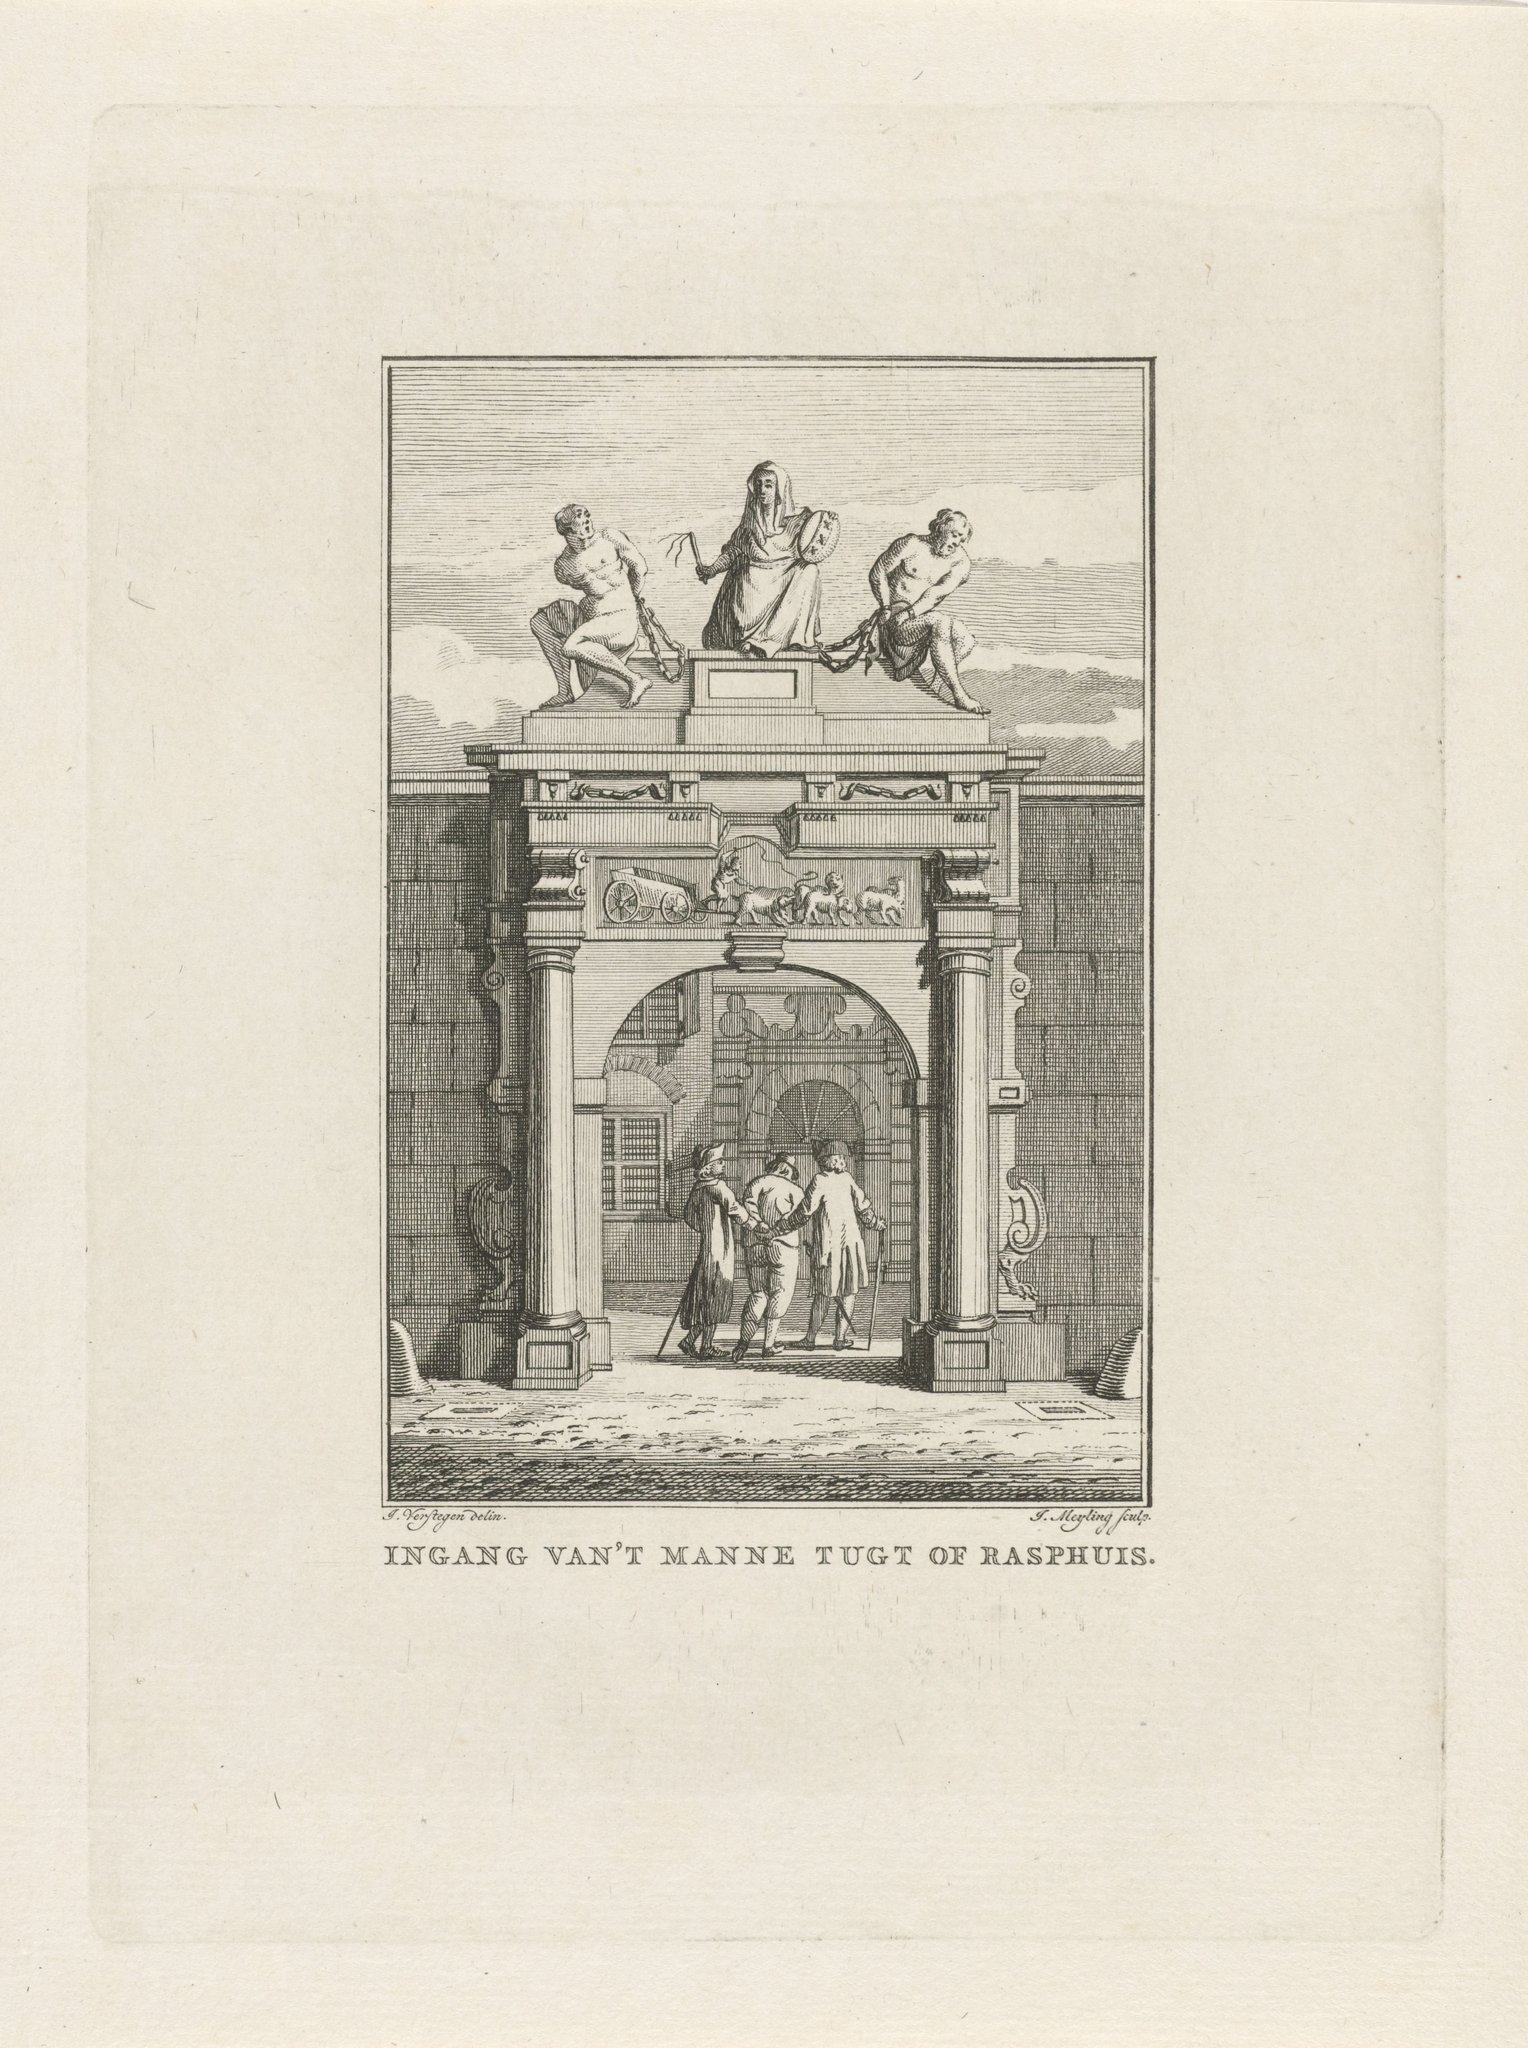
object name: print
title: Gezicht op de Rasphuispoort te Amsterdam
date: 1750-1800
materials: paper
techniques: etching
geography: amsterdam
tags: gate, entrance, punishment; 'castigo', 'pena', 'punitione' (ripa)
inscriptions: collector's mark: Lugt 2228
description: De poort van het Tucht- of Rasphuis aan de Heiligeweg in Amsterdam. De poort wordt bekroond door de Amsterdamse stedenmaagd als de personificatie van de tuchtiging met een zweep en het Amsterdamse stadswapen in haar handen. Zij wordt geflankeerd door twee geboeide naaktfiguren. Door de poort wordt een man het tuchthuis binnen geleid door twee andere mannen.